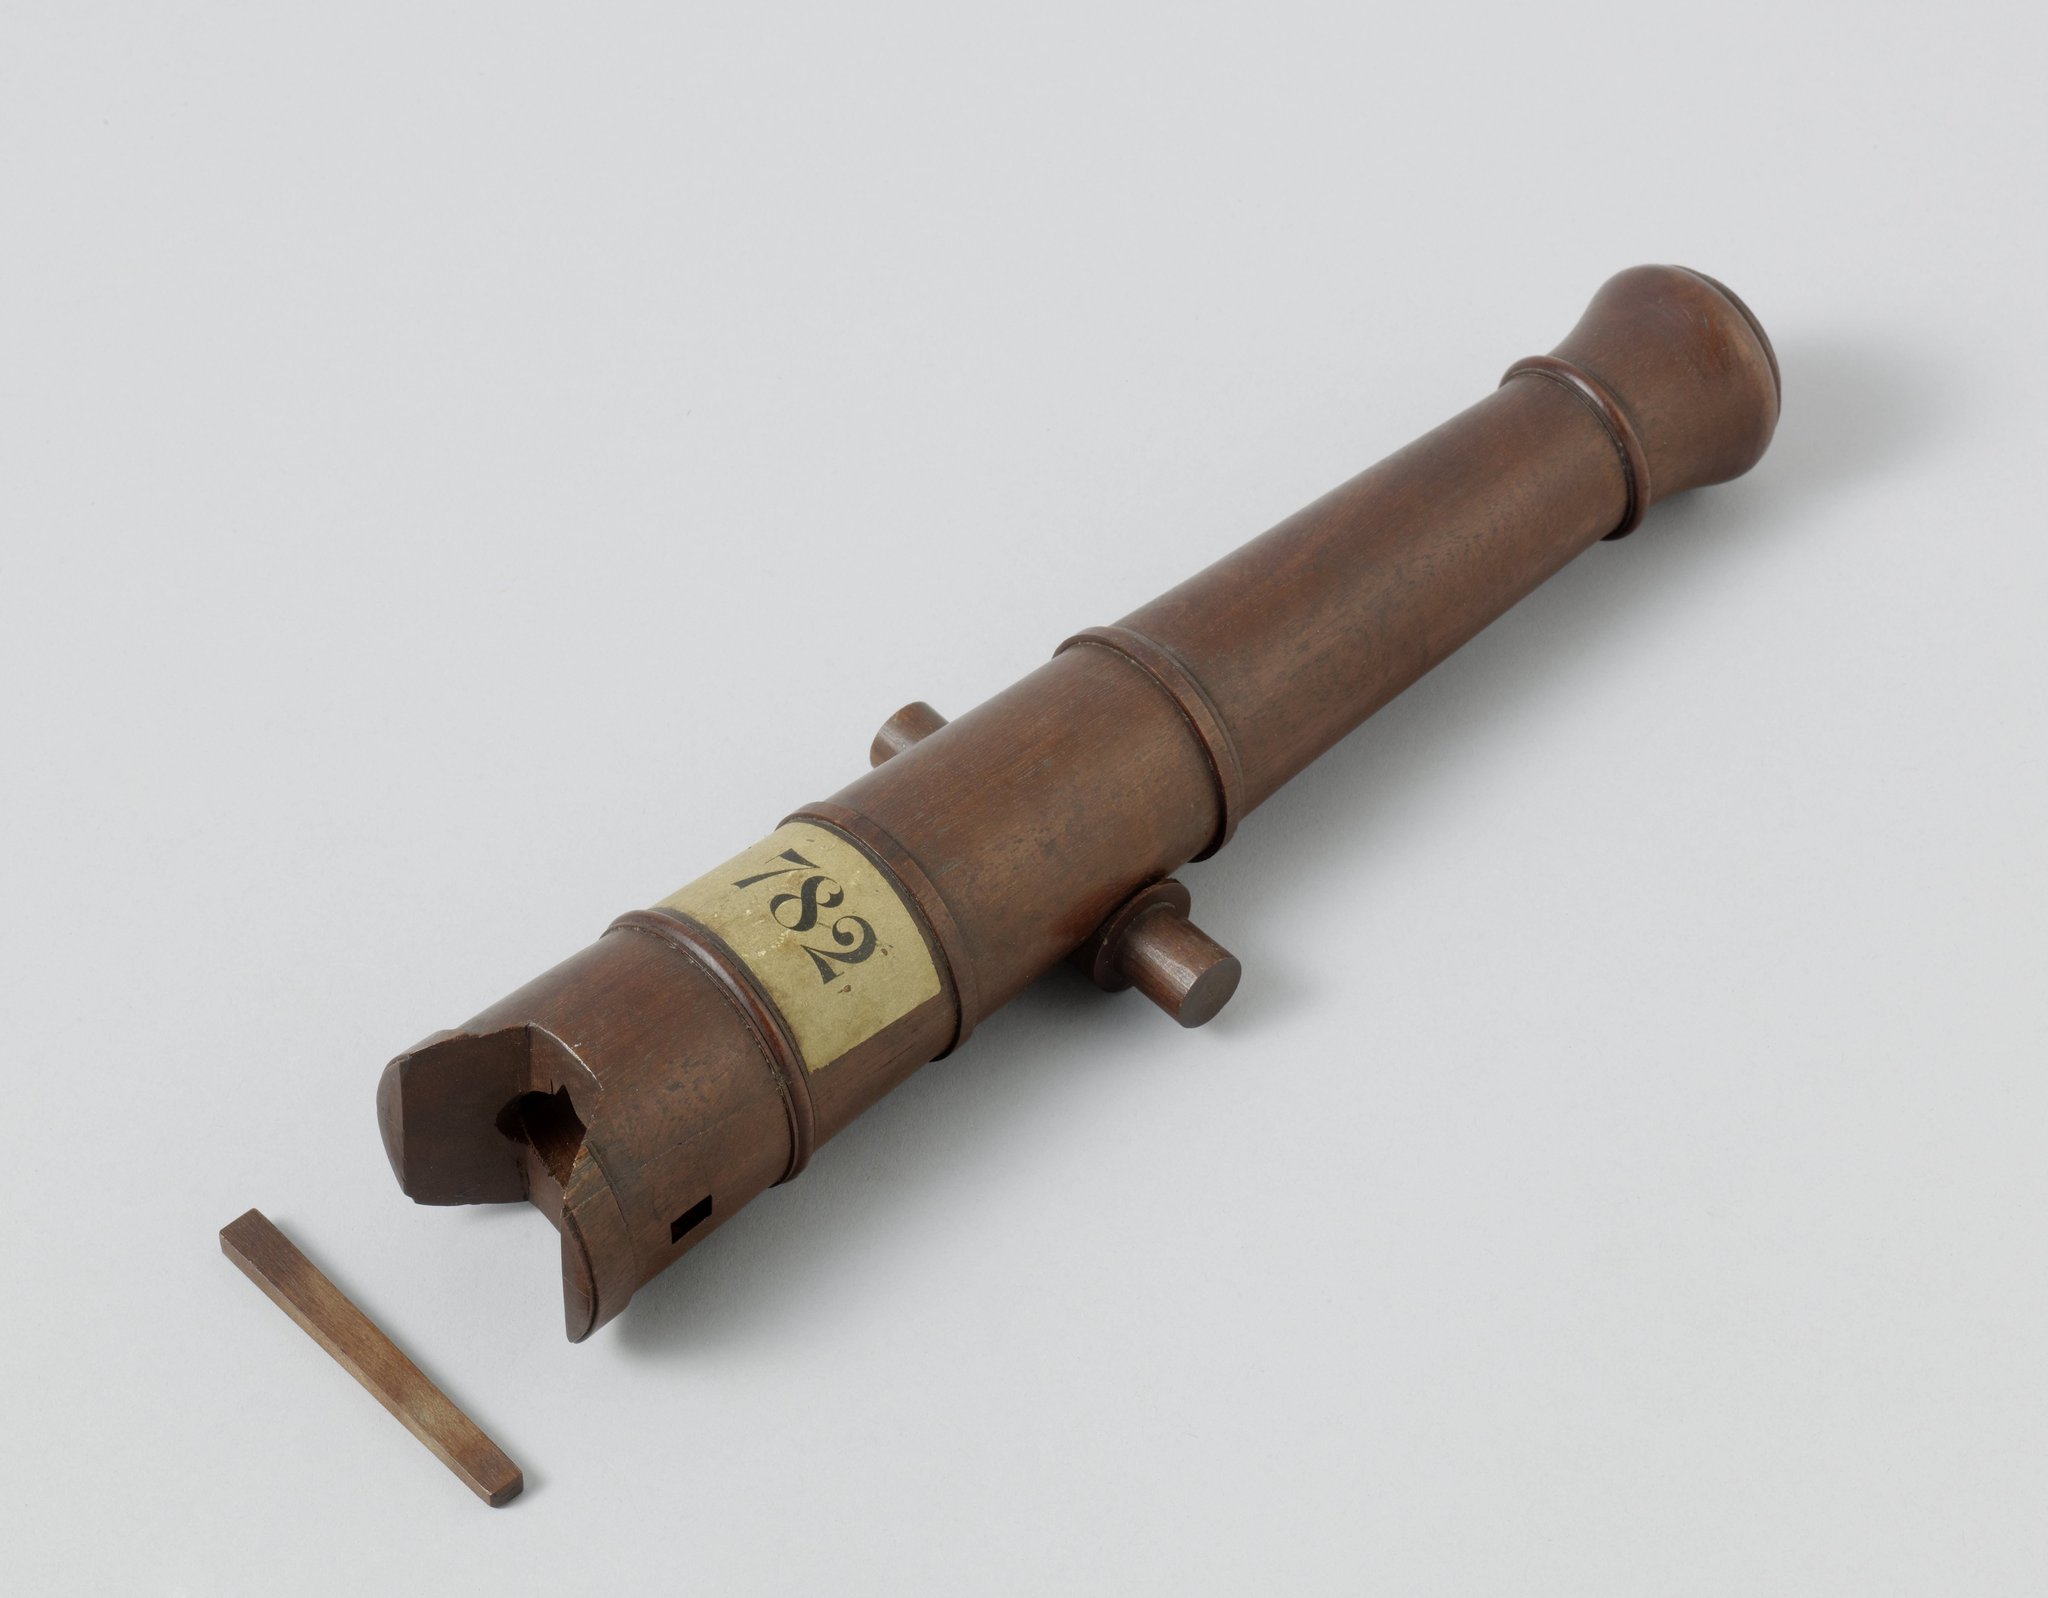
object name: demonstration model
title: Model of a Breech-Loading Gun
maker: Anonymous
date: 1829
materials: wood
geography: netherlands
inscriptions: label, on the barrel: ‘782’ former inventory label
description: Het model stelt waarschijnlijk een kanon van 24 pond voor. Ampt diende zijn voorstel voor achterlaadgeschut bij de Marine in op 2 juni 1829. Wanneer dit model werd overhandigd, is onduidelijk. Het ontwerp had als bijkomend voordeel dat de geschutspoort klein en rond kon blijven. De artillerie-officieren, waaronder Sesseler, keurden zijn ontwerpen af.